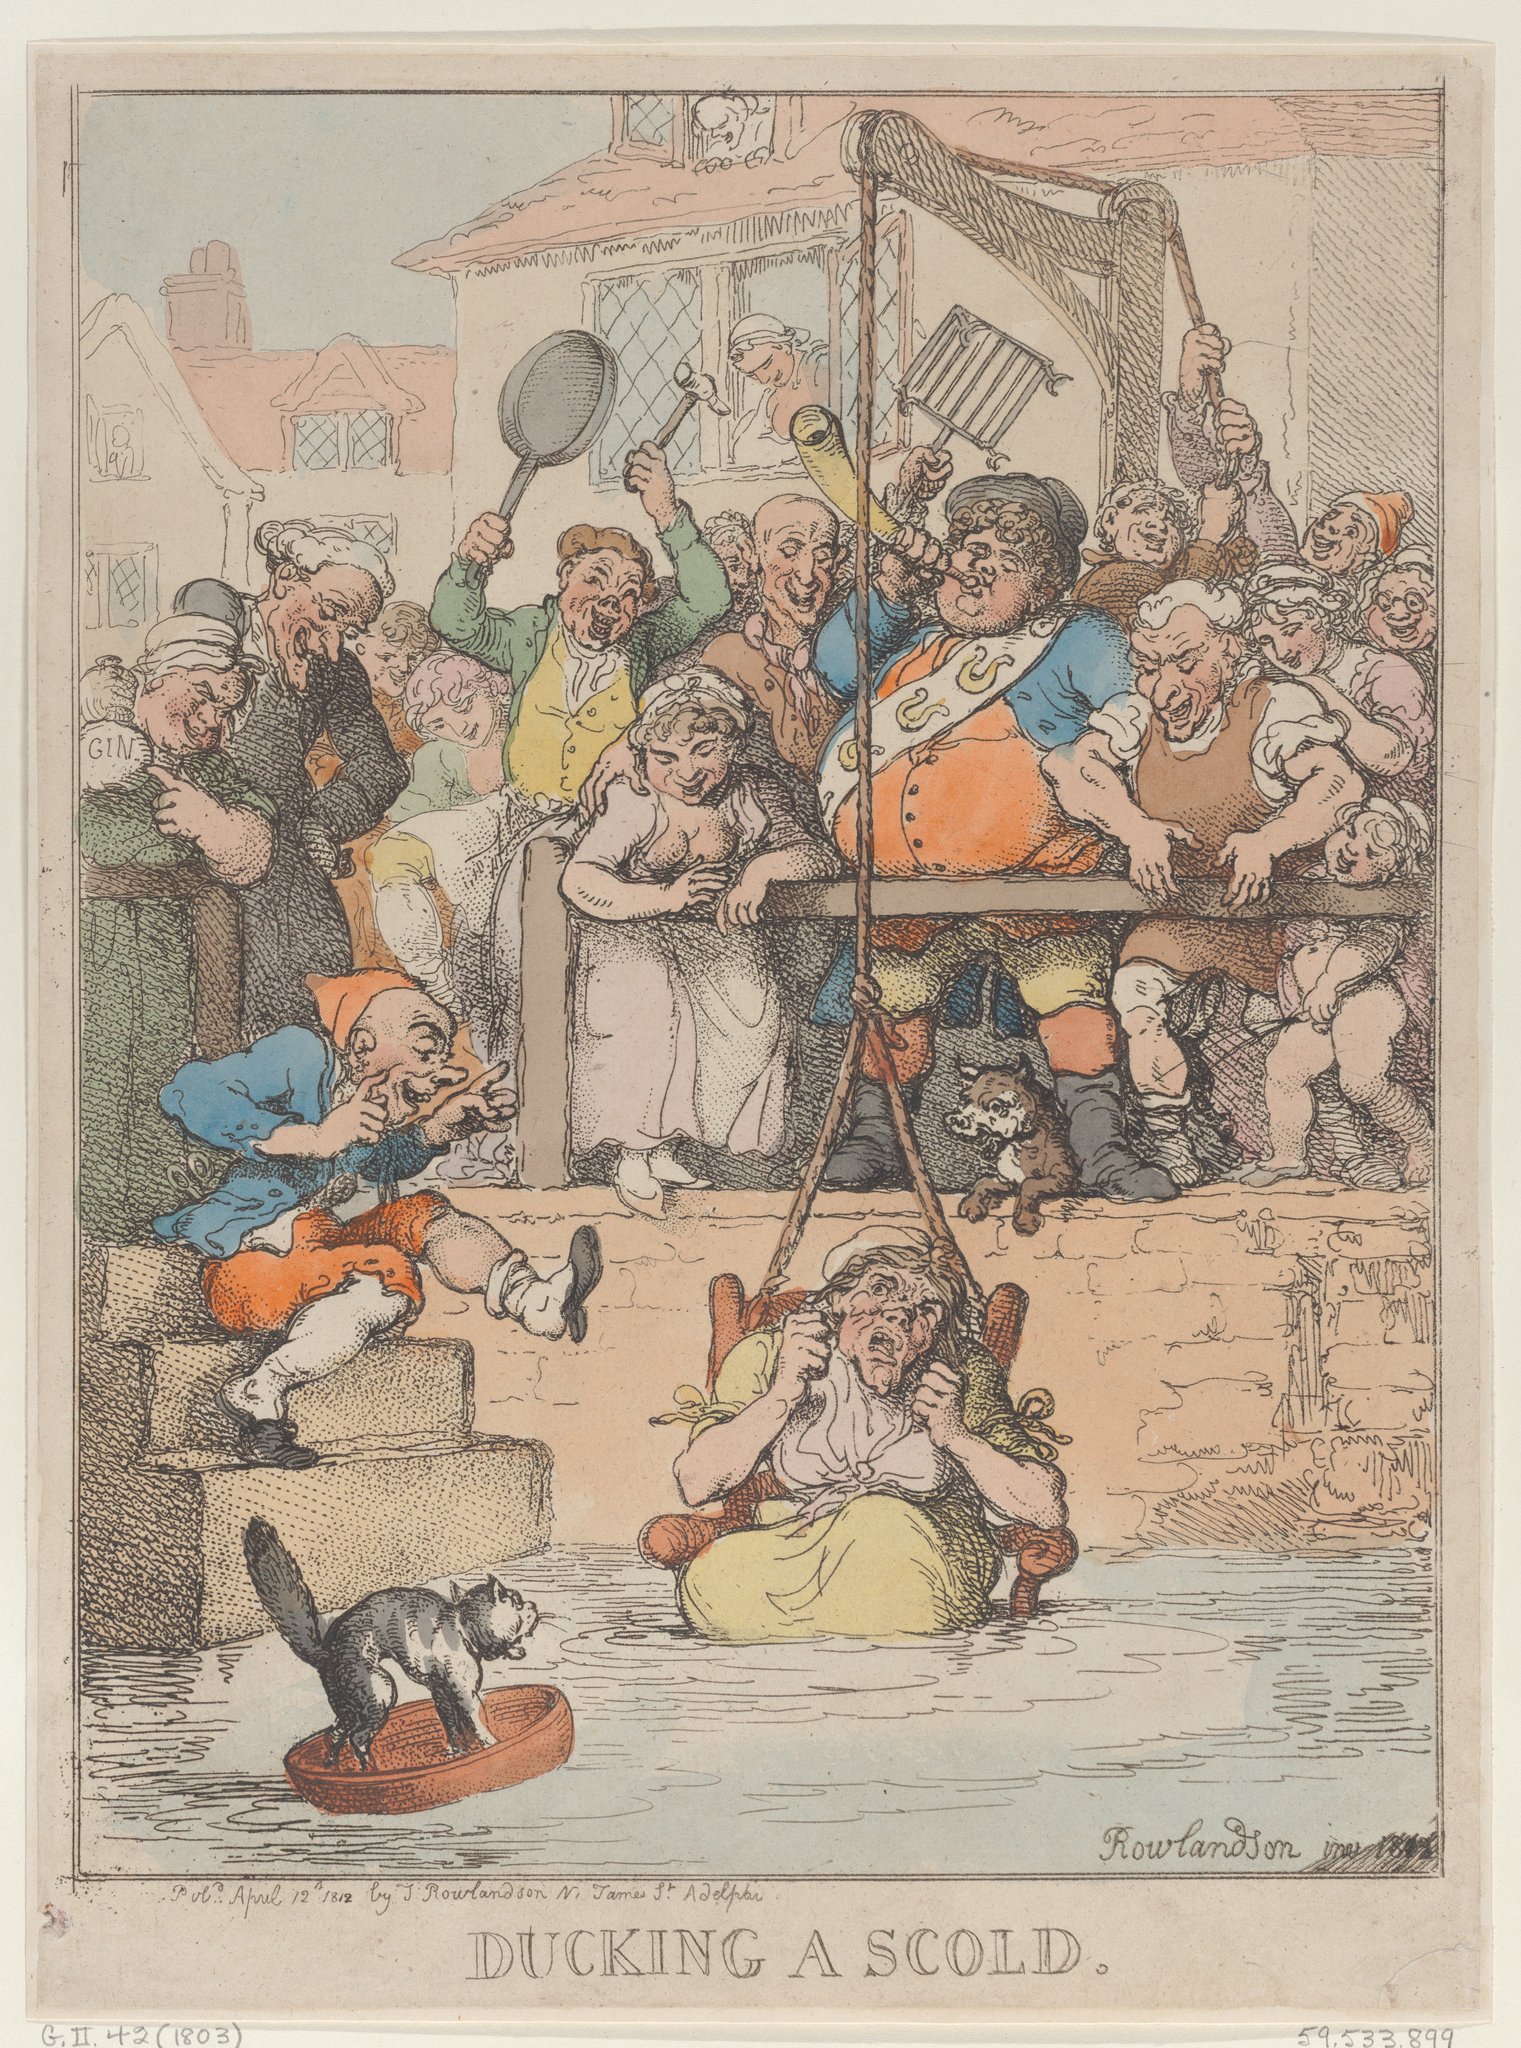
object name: print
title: Ducking a Scold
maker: thomas rowlandson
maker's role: artist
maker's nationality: british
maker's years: 1757-1827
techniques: etching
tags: satire,men,women,cats